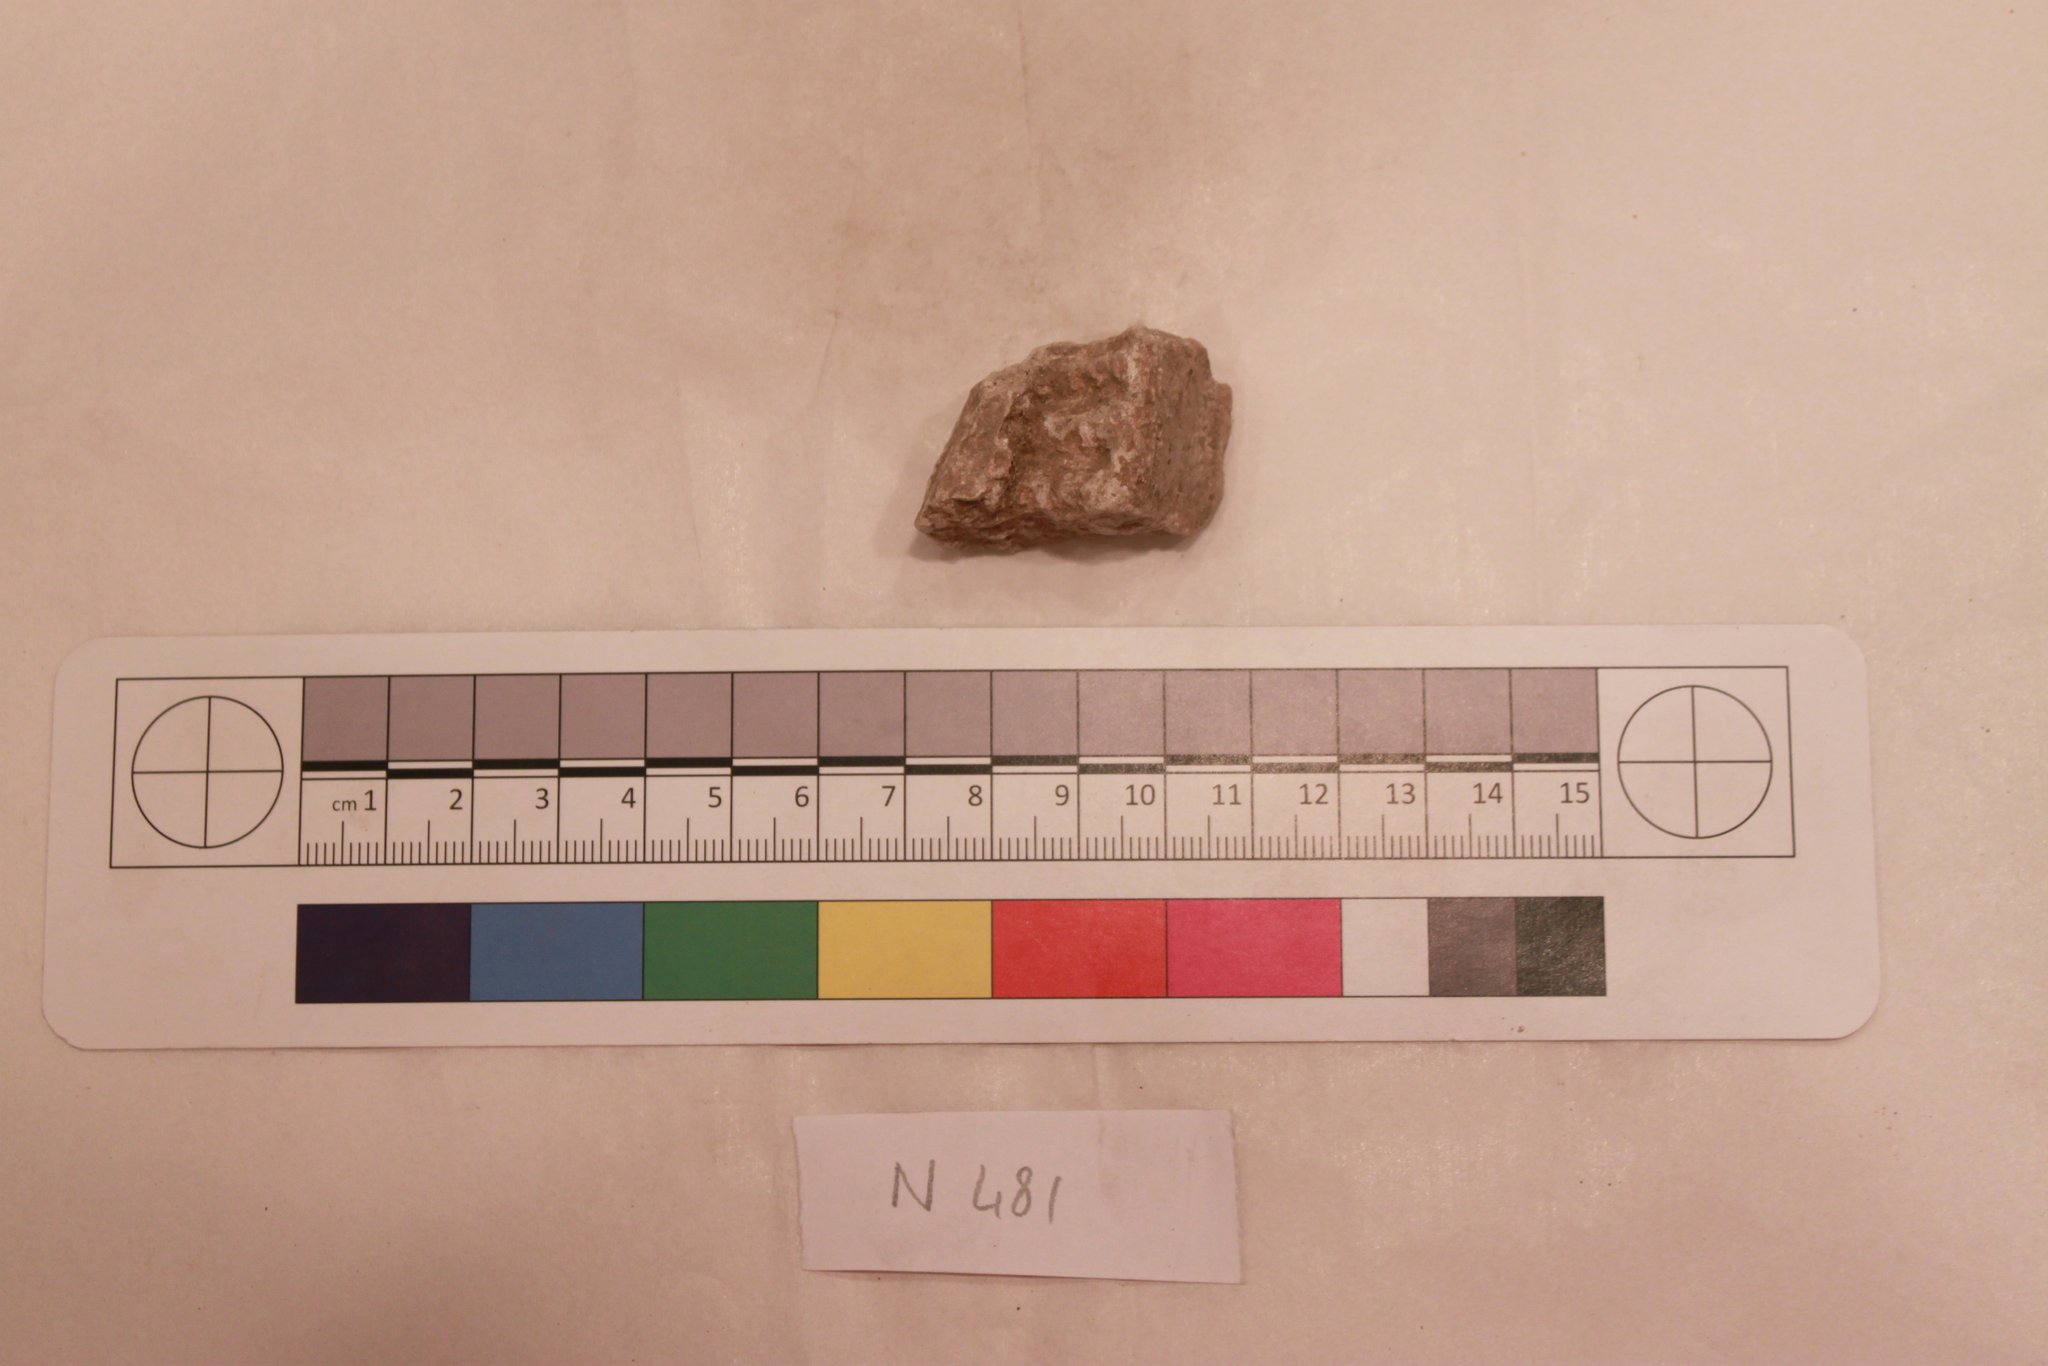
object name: fragment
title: Stucco Fragment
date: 701-1200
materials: plaster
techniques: carving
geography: iran